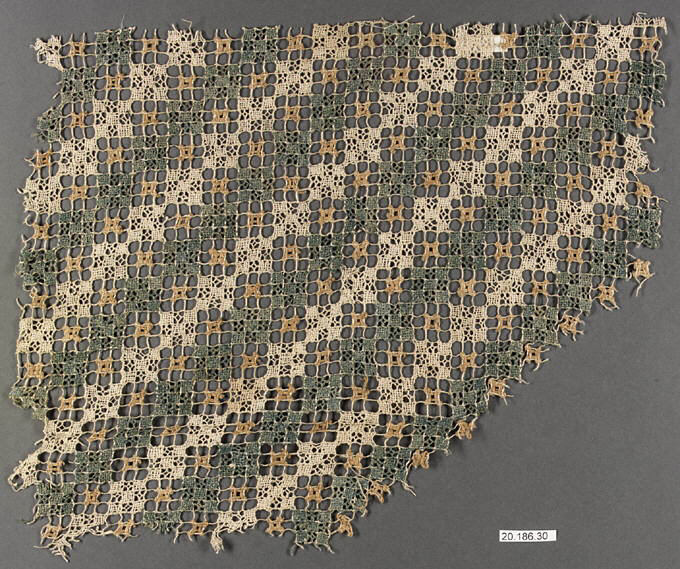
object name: piece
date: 1501-1600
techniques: embroidery